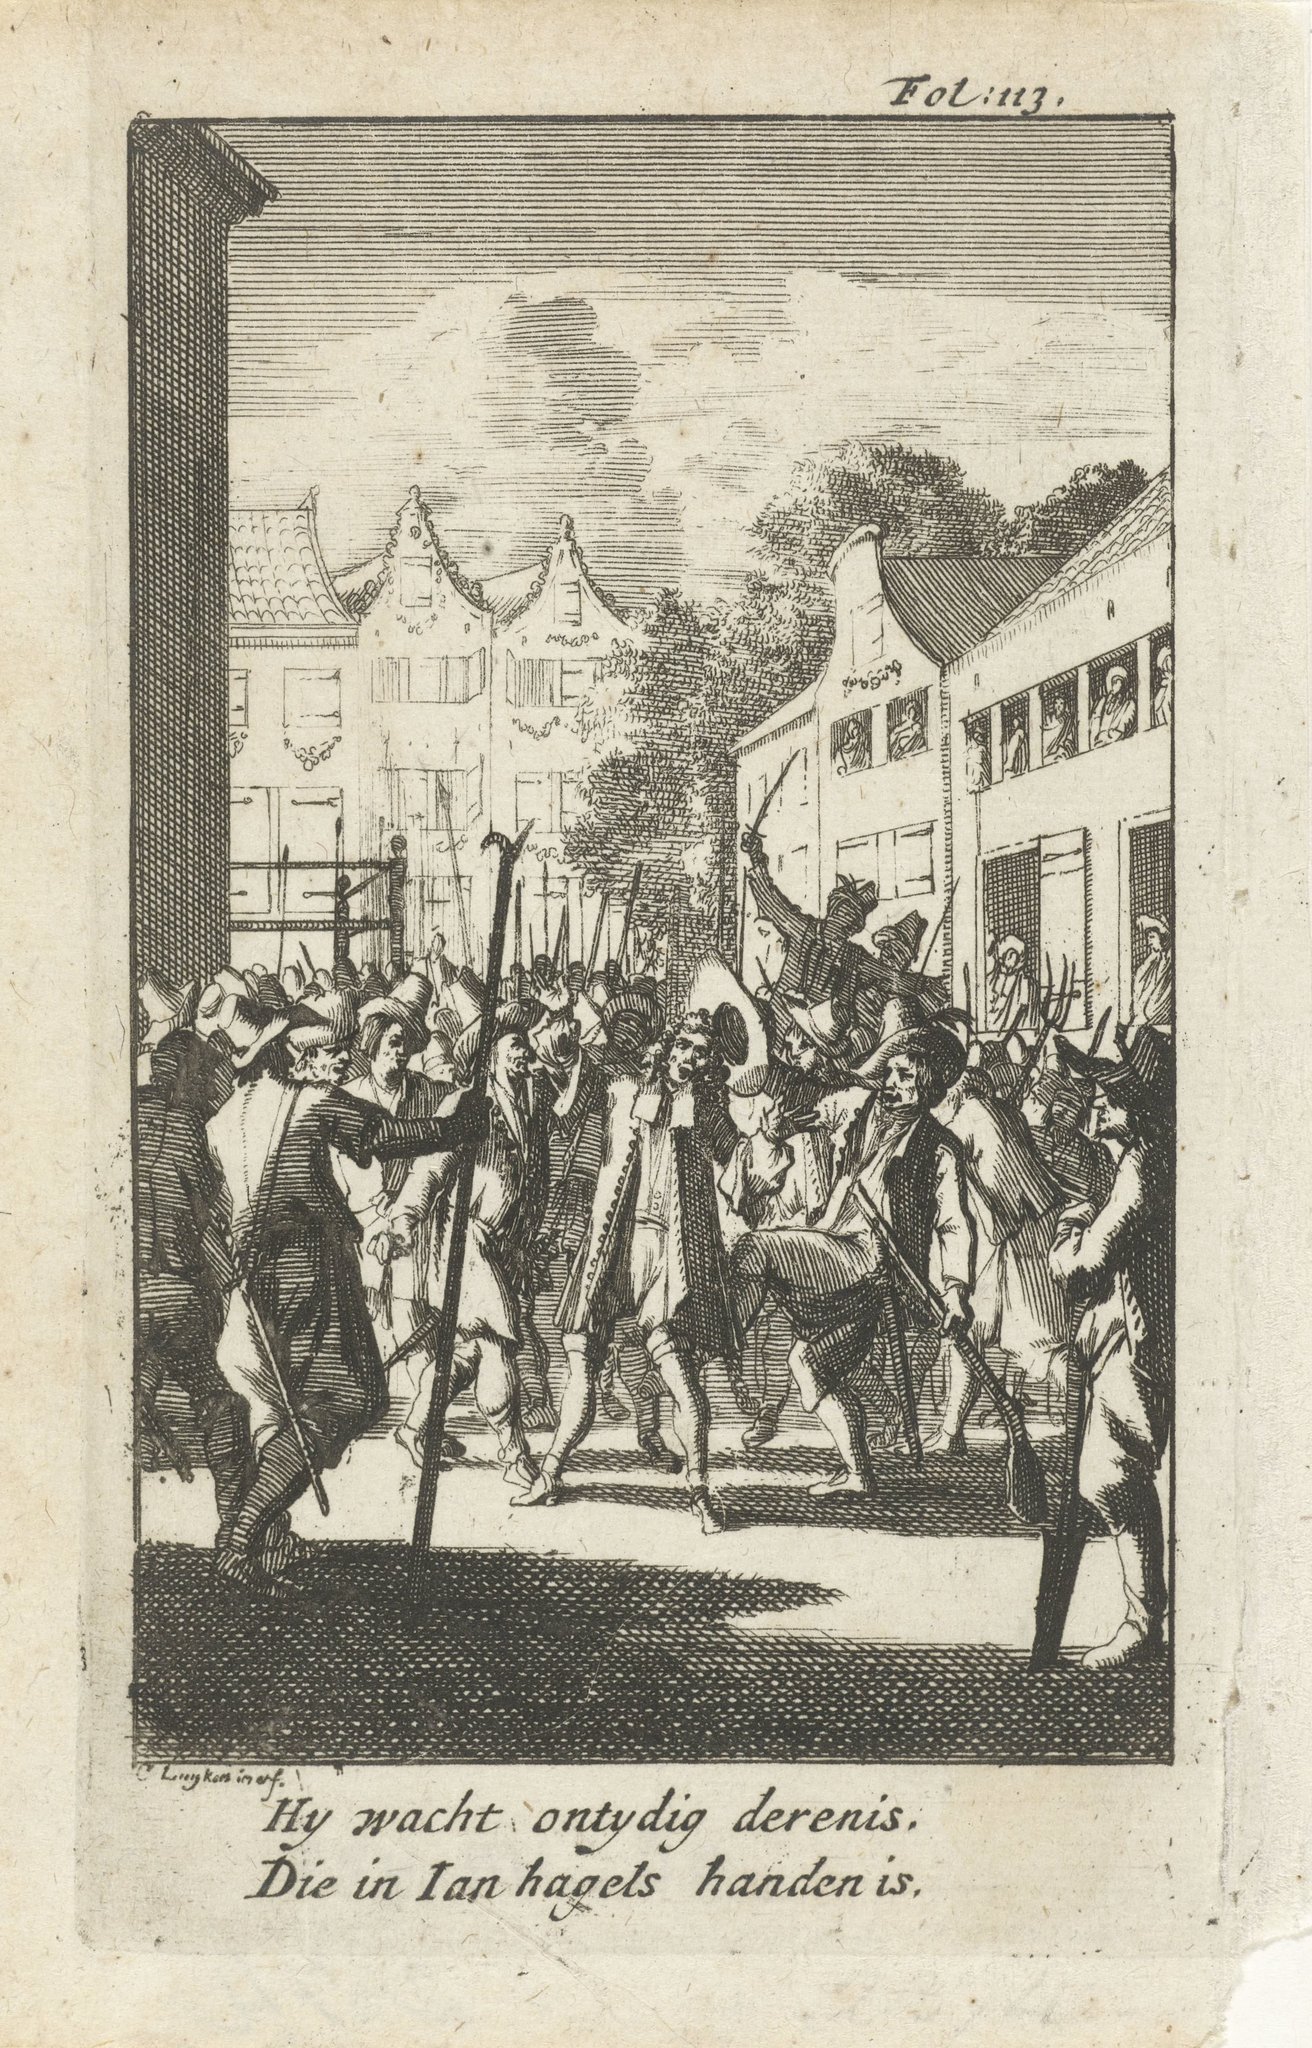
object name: book illustration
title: Nicolaas Reigersberge op straat aangevallen, 1672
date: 1692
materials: paper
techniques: etching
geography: amsterdam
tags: mayor, street-fights, riots, middelburg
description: Illustratie uit: Beronicius, Petrus Johannes. Boeren- en overheidsstrĳd. Amsterdam: Jan Claesz ten Hoorn, 1692.